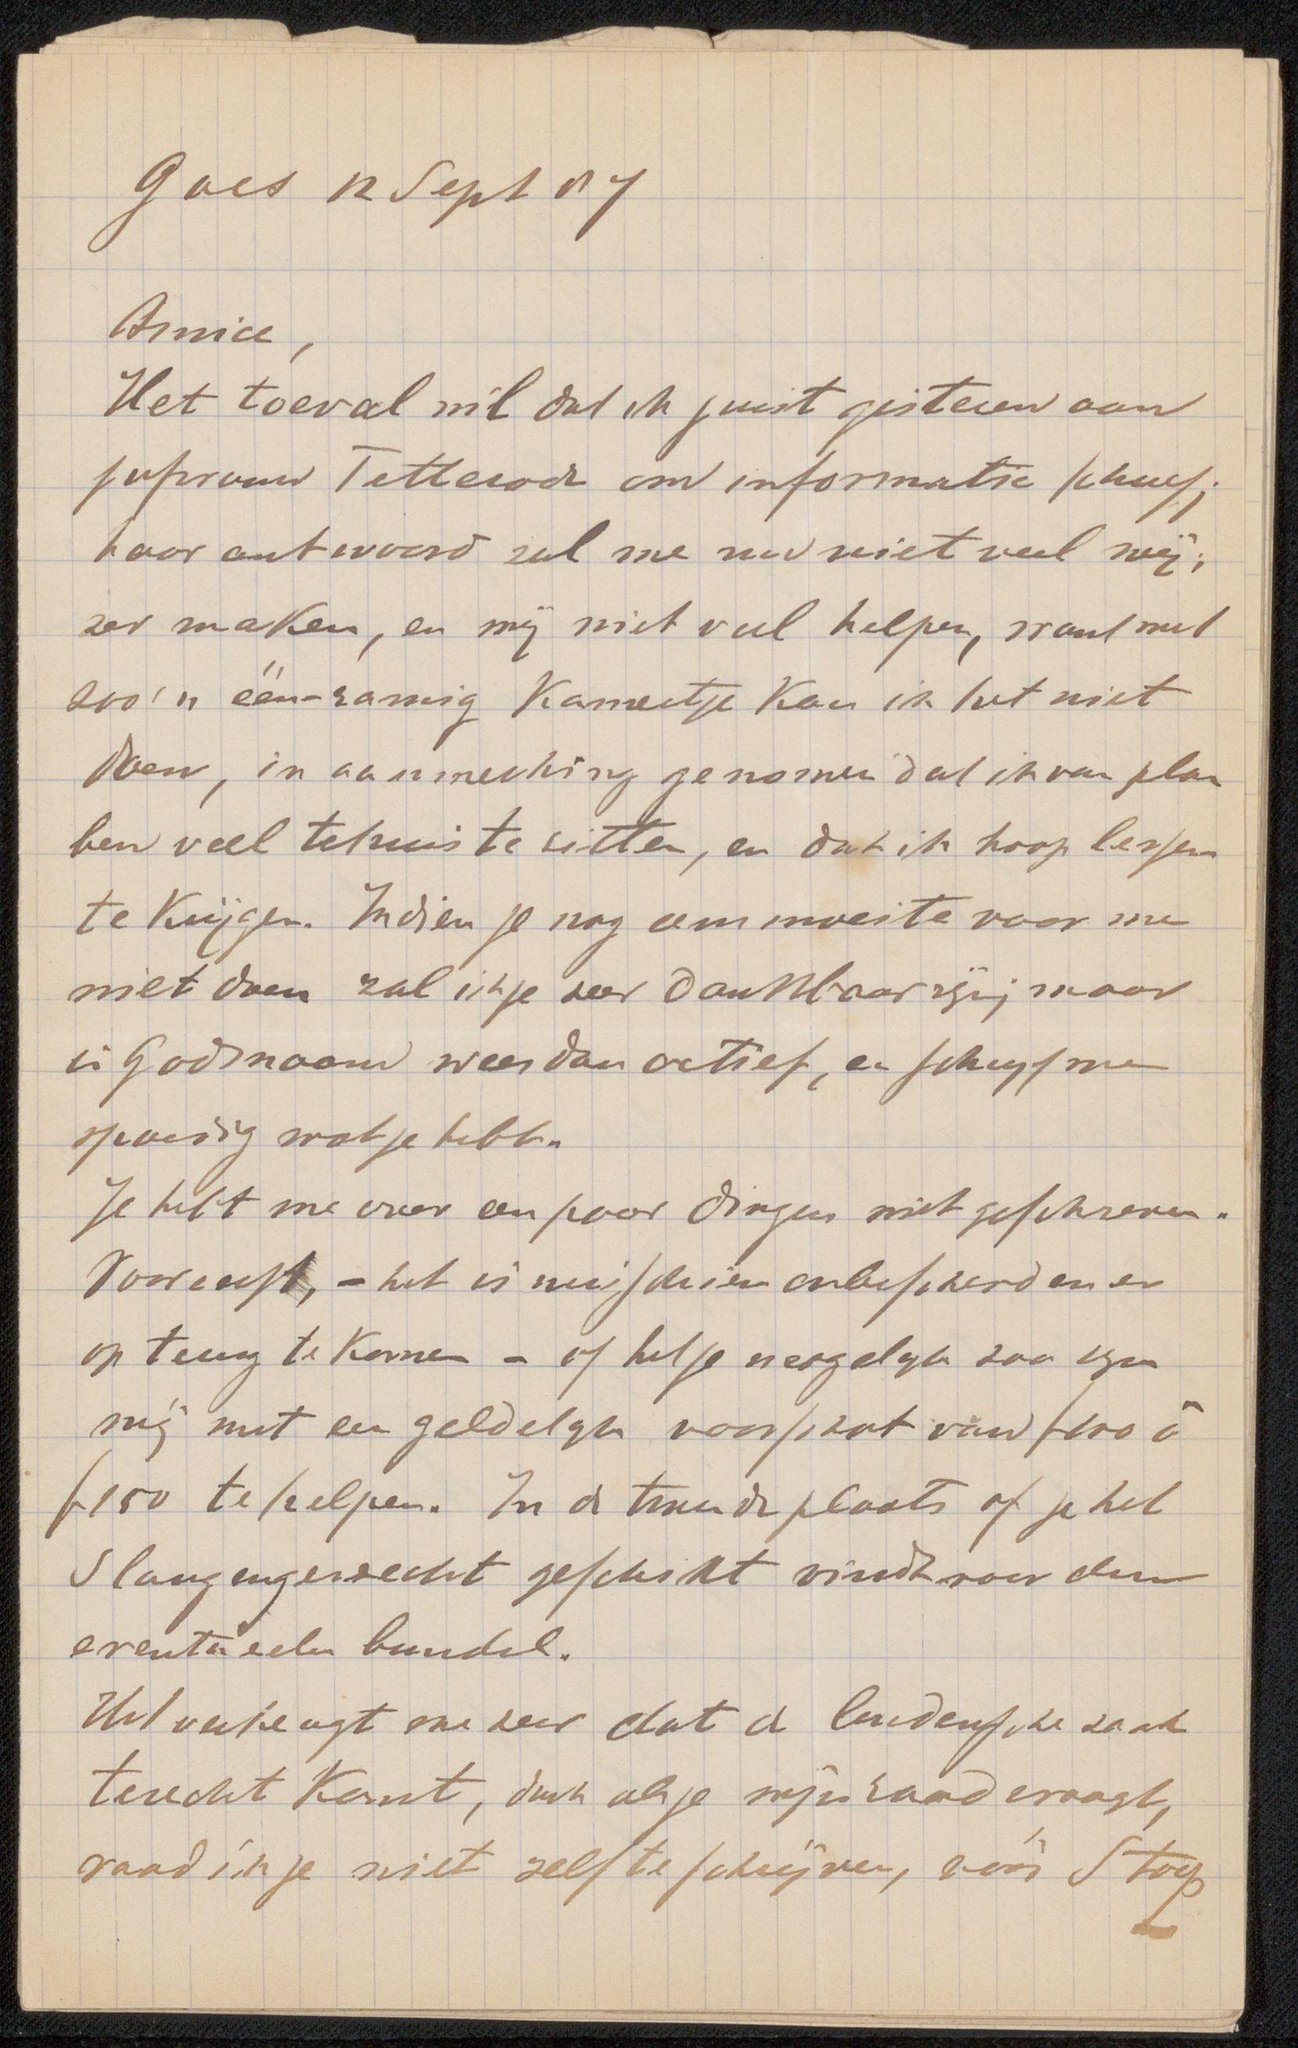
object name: letter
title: Brief aan Jan Veth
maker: chap van deventer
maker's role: kunstcriticus, scheikundige, schrijver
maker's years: 1860-1931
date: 1887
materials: ink, paper, pencil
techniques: pen, writing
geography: goes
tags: dordrecht, amsterdam, painter, print maker, draughtsman, designer, jan veth, albert verwey, money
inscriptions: collector's mark: ‘RPK’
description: Brief bevat achttien gedichten op losse vellen.